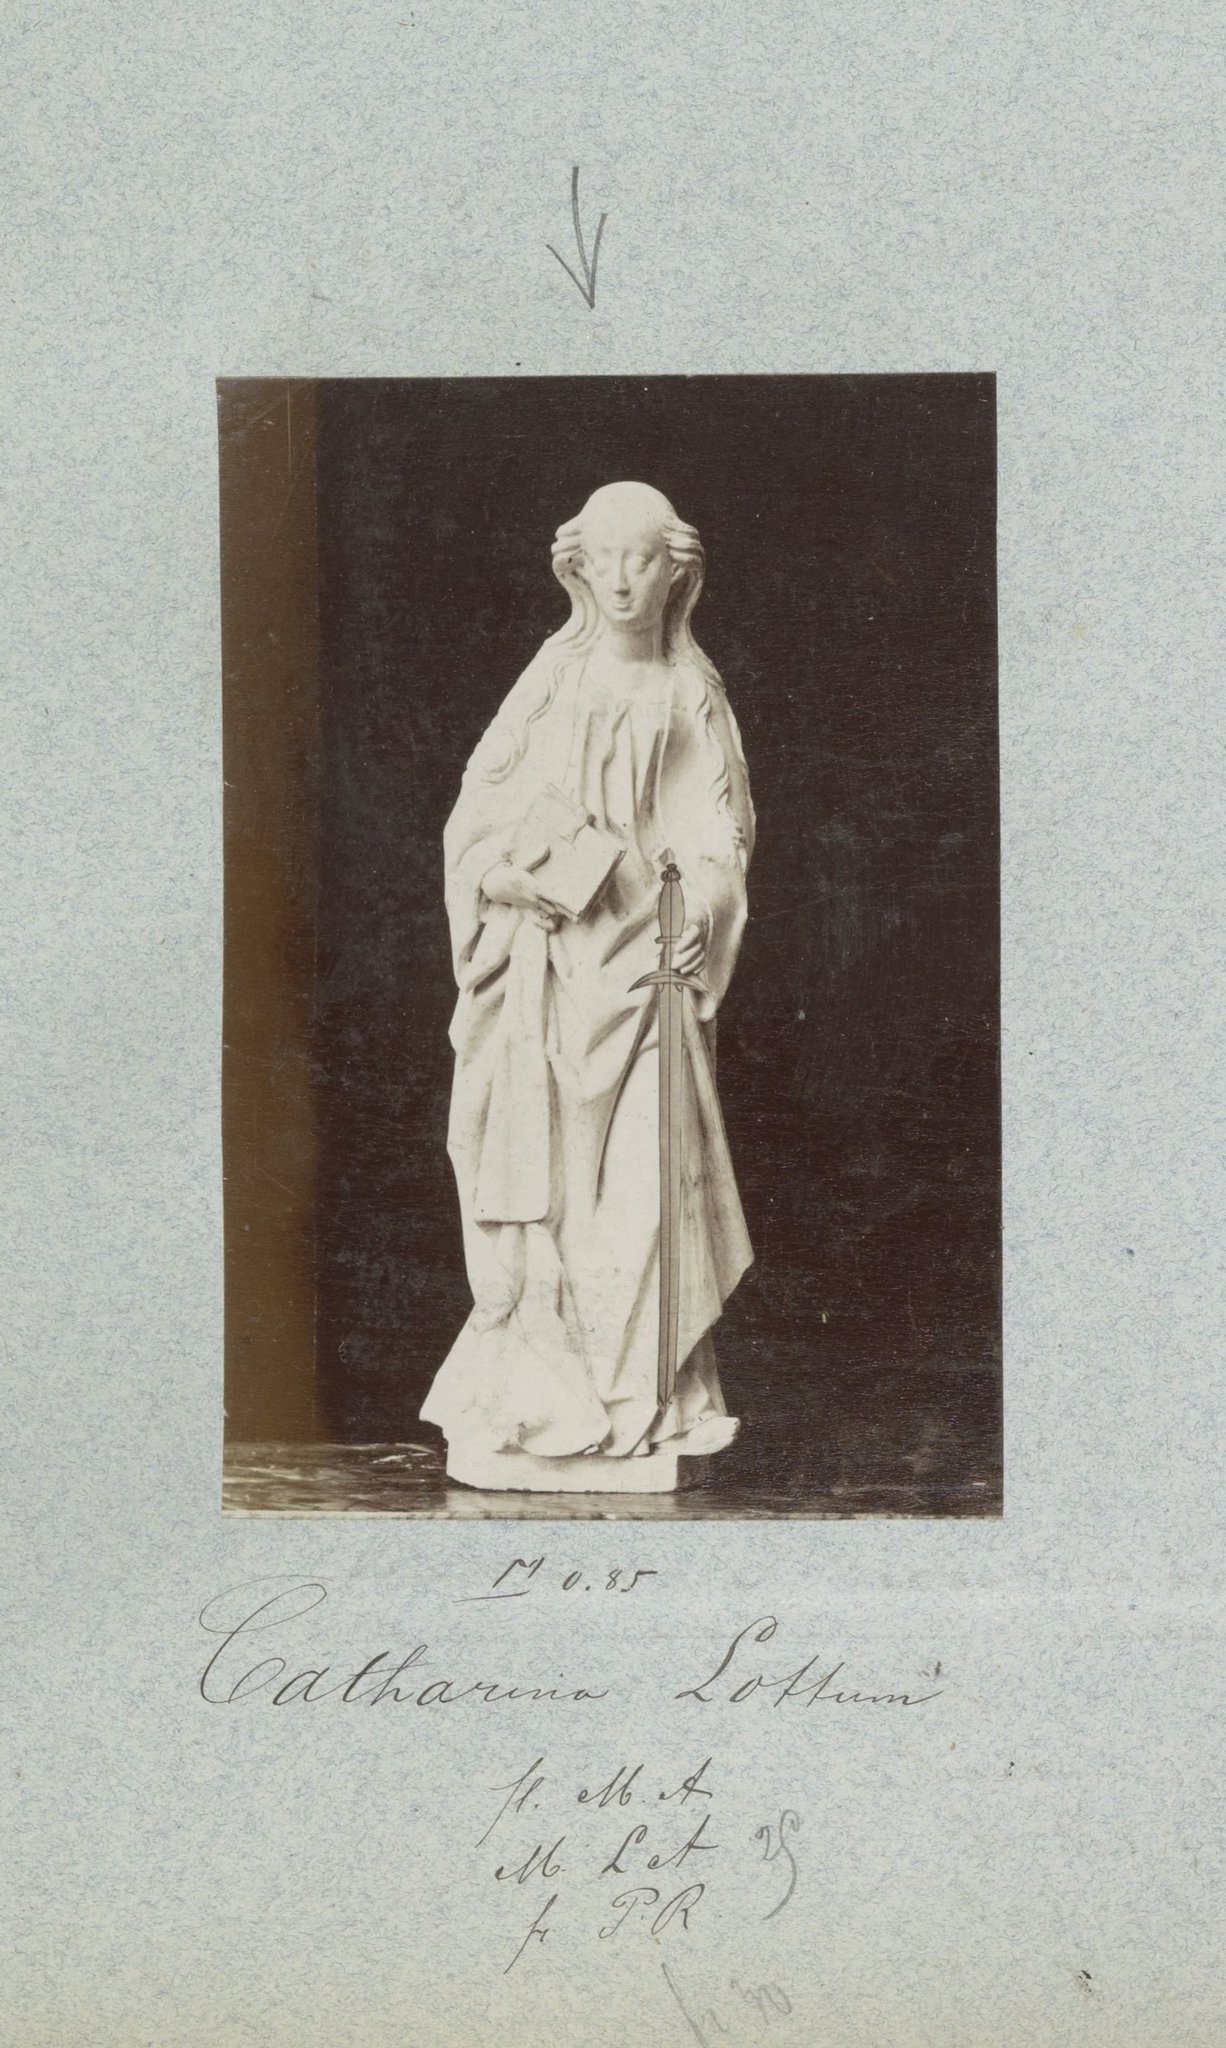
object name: album leaf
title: Gipsen afgietsel van een sculptuur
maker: Anonymous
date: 1875-1900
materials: paper, photographic support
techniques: albumen print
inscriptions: annotation, annotation: ‘Catharina Lottum’, annotation: ‘M 0.85’